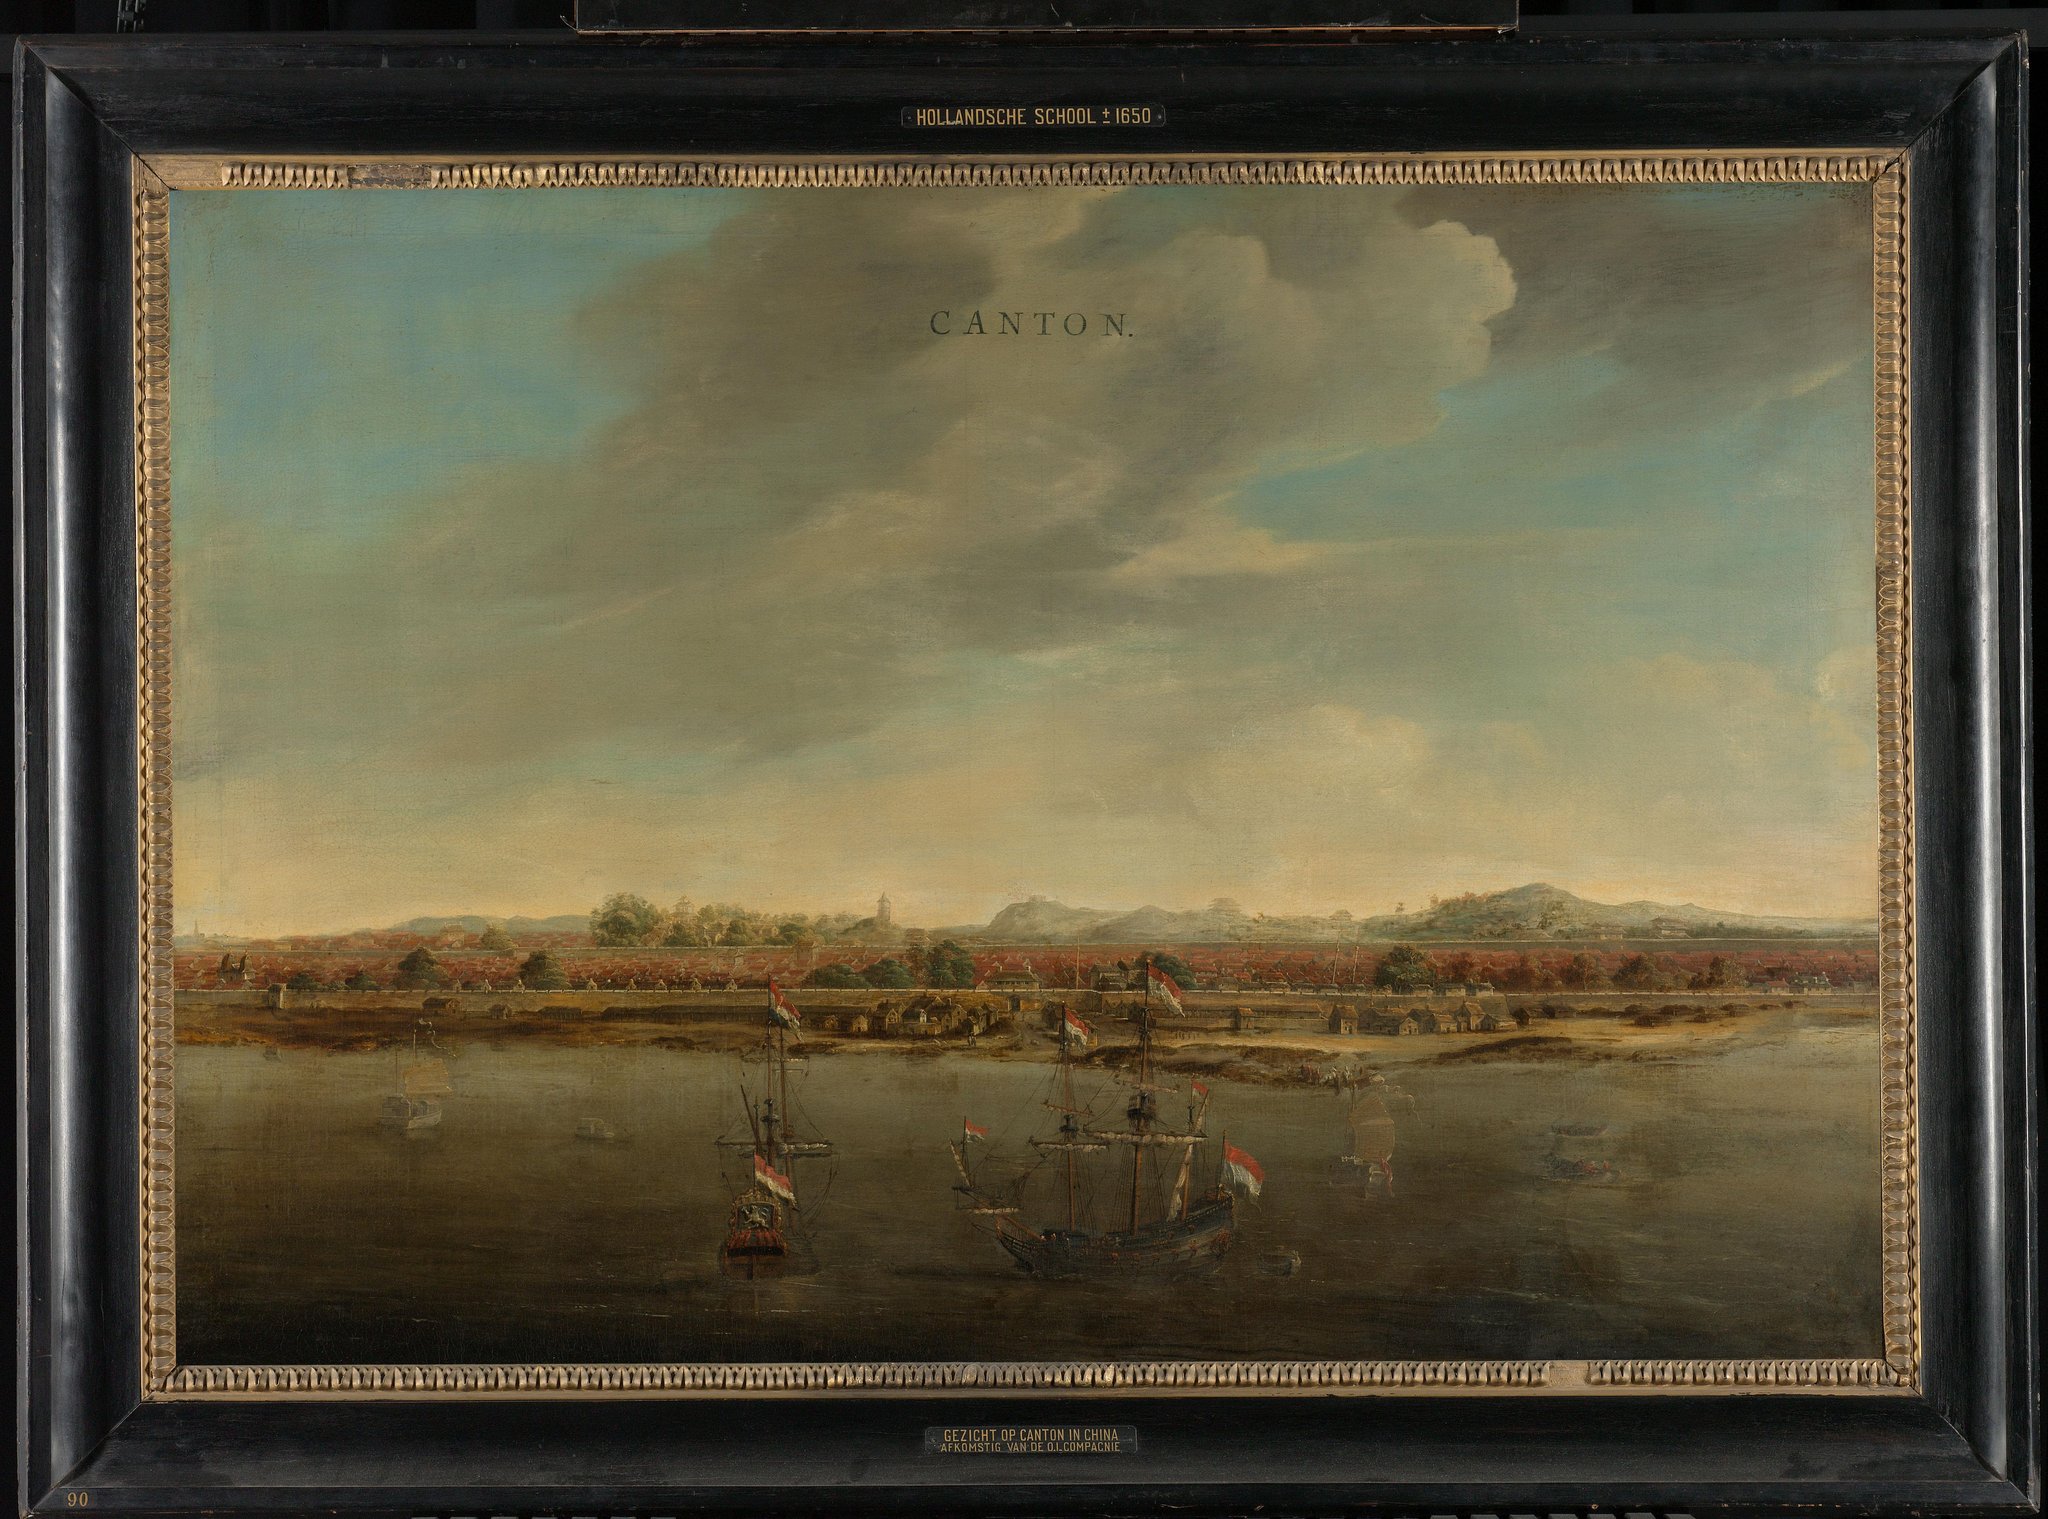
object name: frame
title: Zwarte profiellijst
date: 1400-1950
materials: wood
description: Zwarte profiellijst. In 2012 is de lijst gerestaureerd en is de vergulde rand met tulpmotief verwijderd